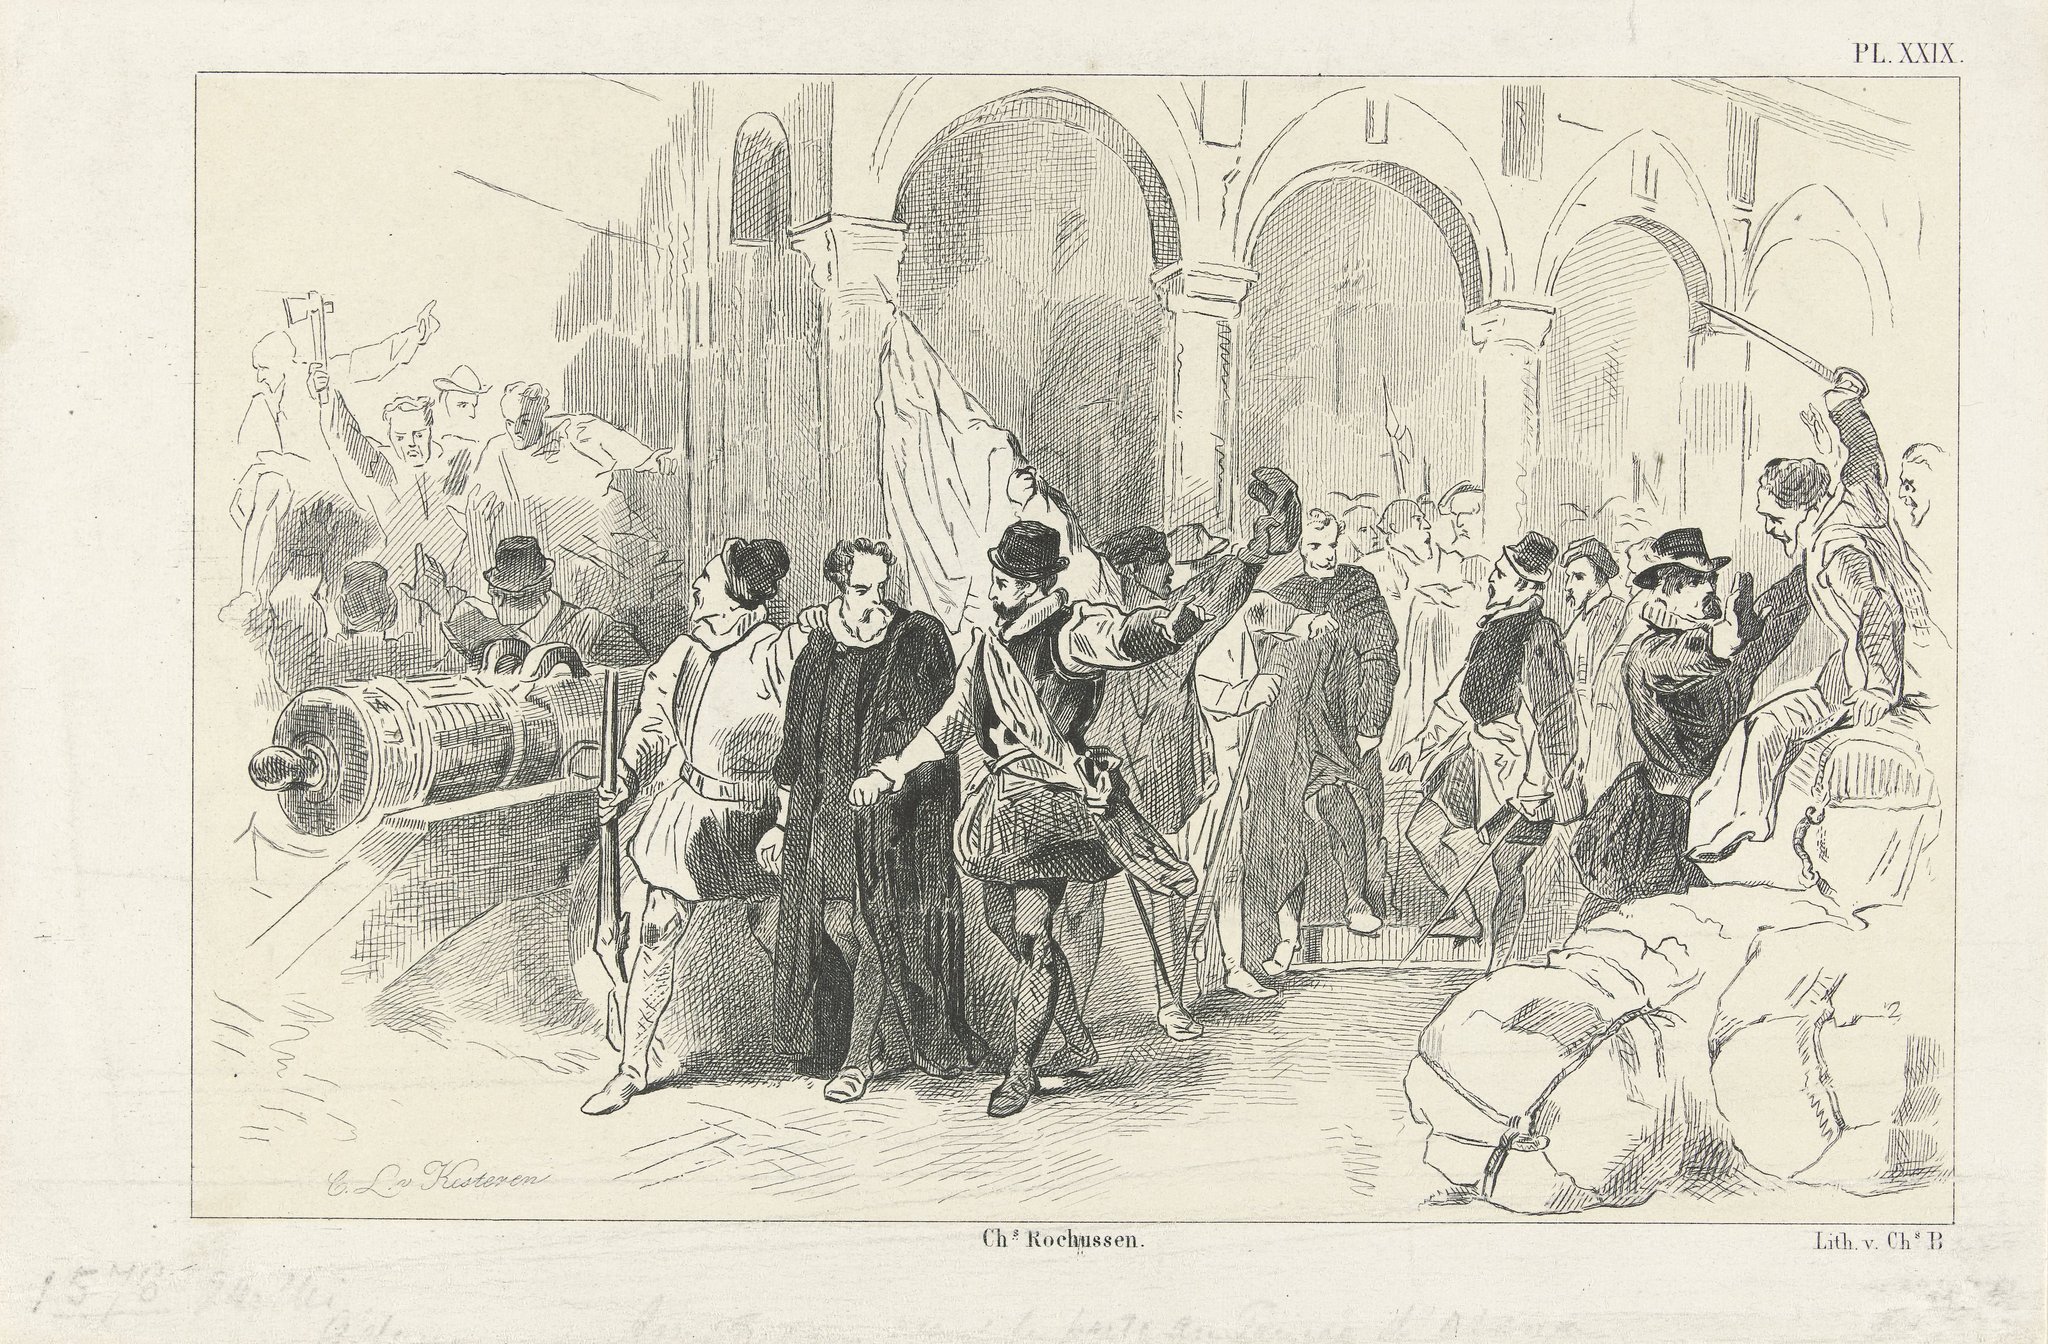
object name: print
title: Amsterdam kiest de Staatse zijde, 1578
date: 1853-1861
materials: paper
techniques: tone lithography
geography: netherlands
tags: stadhuis van amsterdam (14e eeuw-1652), alteratie van amsterdam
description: De Alteratie van Amsterdam: Amsterdam kiest de Staatse zijde, 26 mei 1578. Leden van het Spaansgezinde stadsbestuur worden door soldaten afgevoerd. Links en rechts joelende stedelingen.